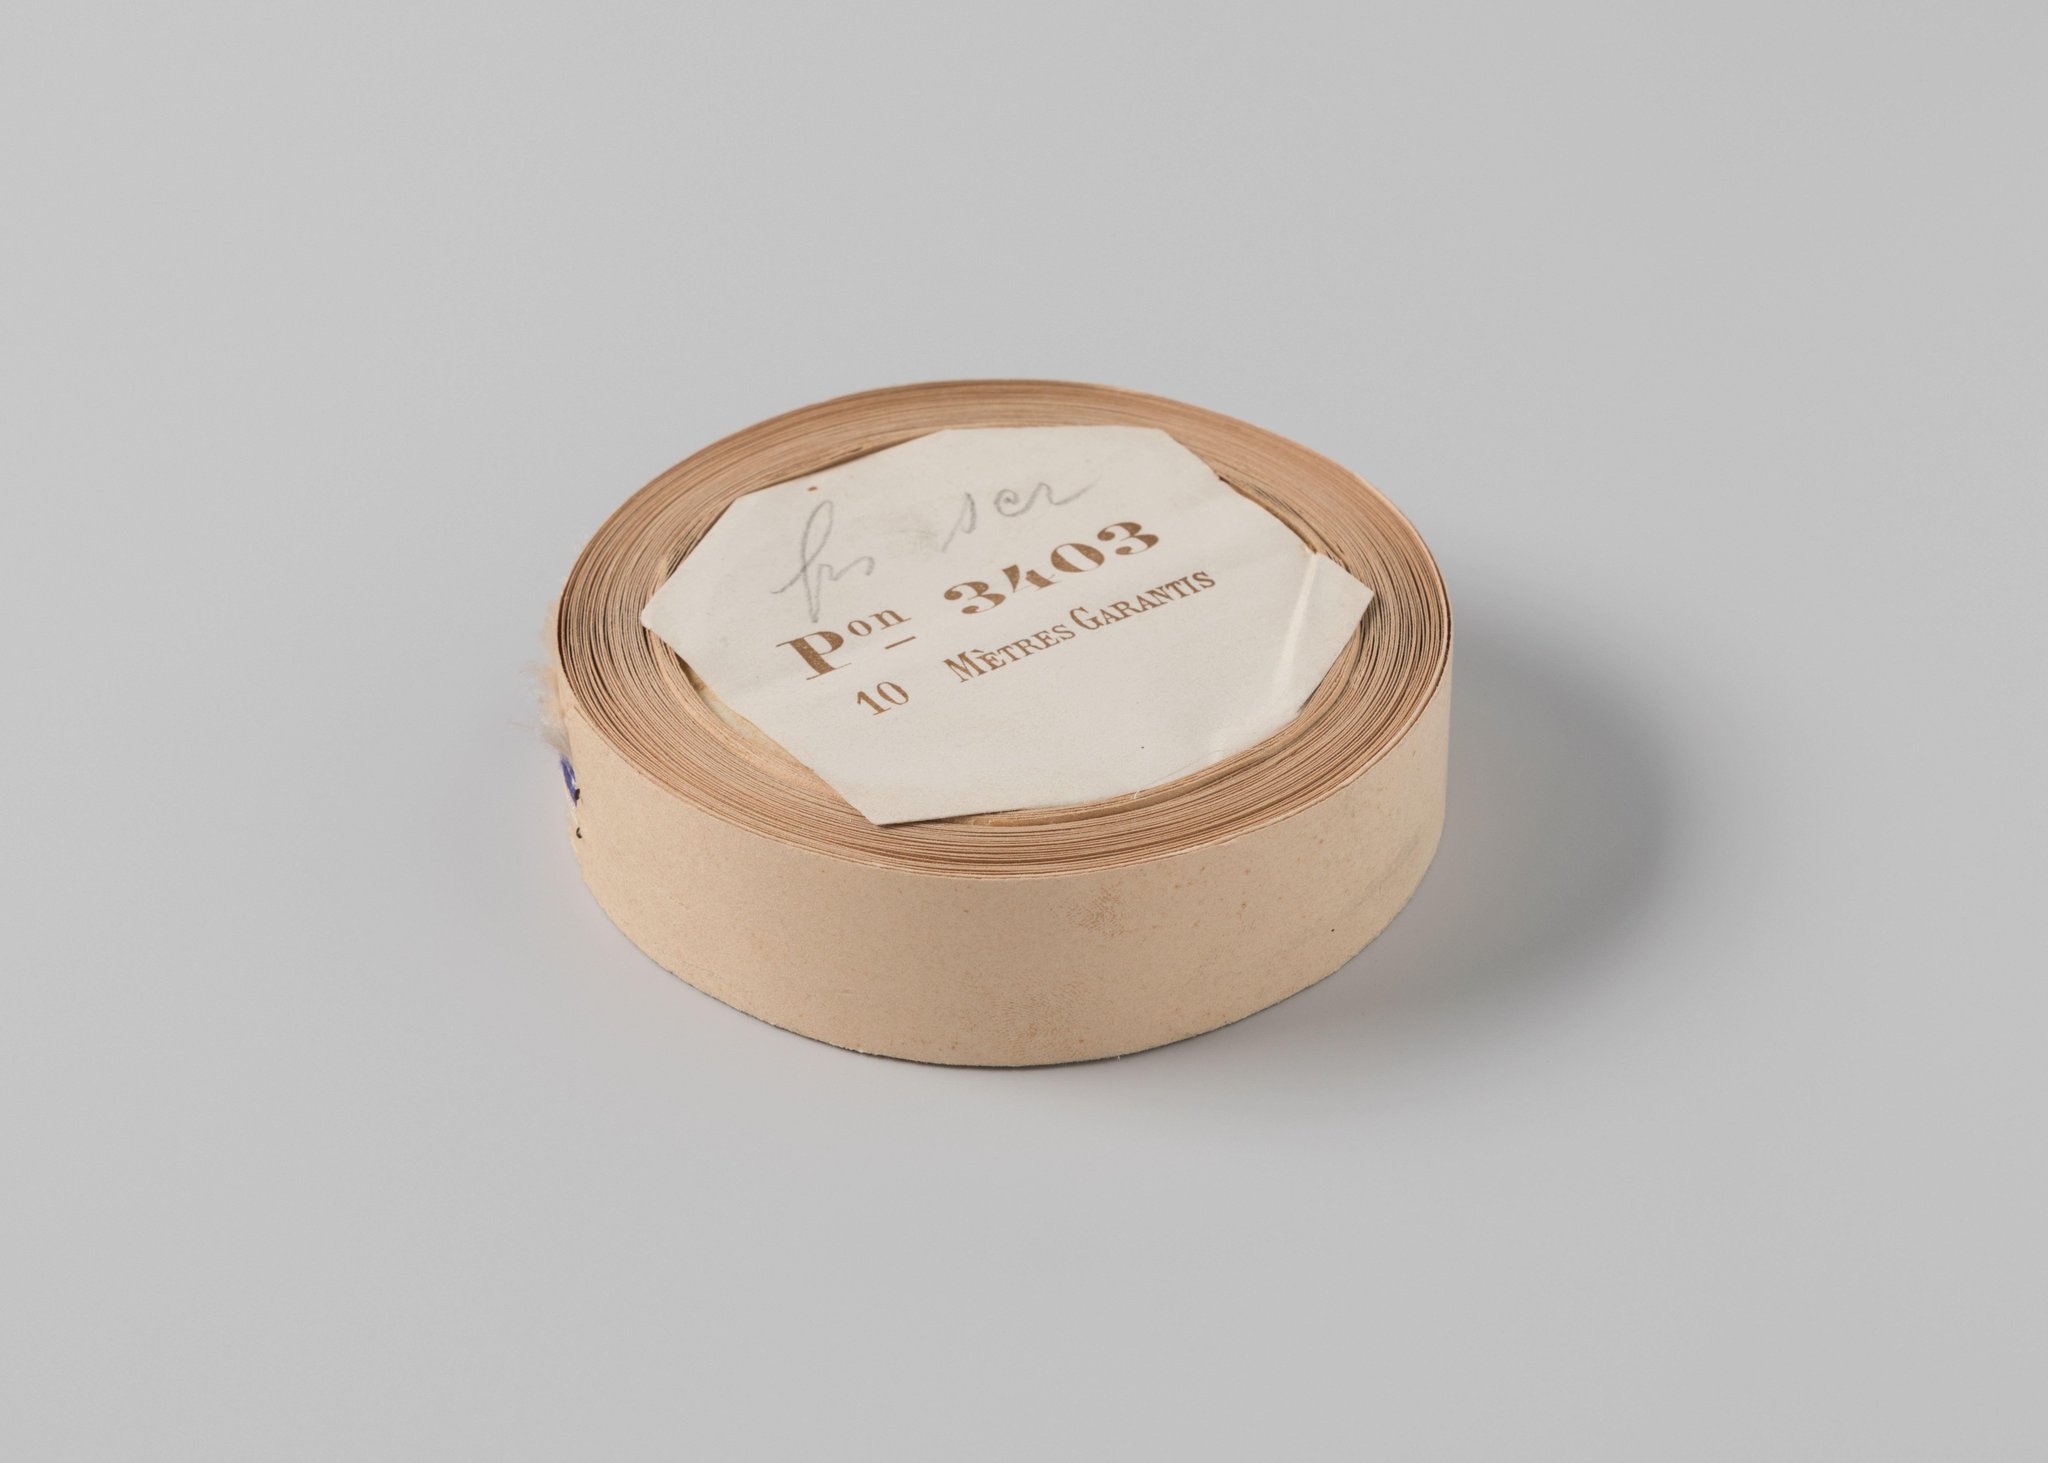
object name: braid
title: Rol met wit lint met één gerafelde zijde en drie blauwe horizontale strepen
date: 1930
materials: cardboard, paper, textile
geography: france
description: Rol met wit lint met één gerafelde zijde en drie blauwe horizontale strepen.